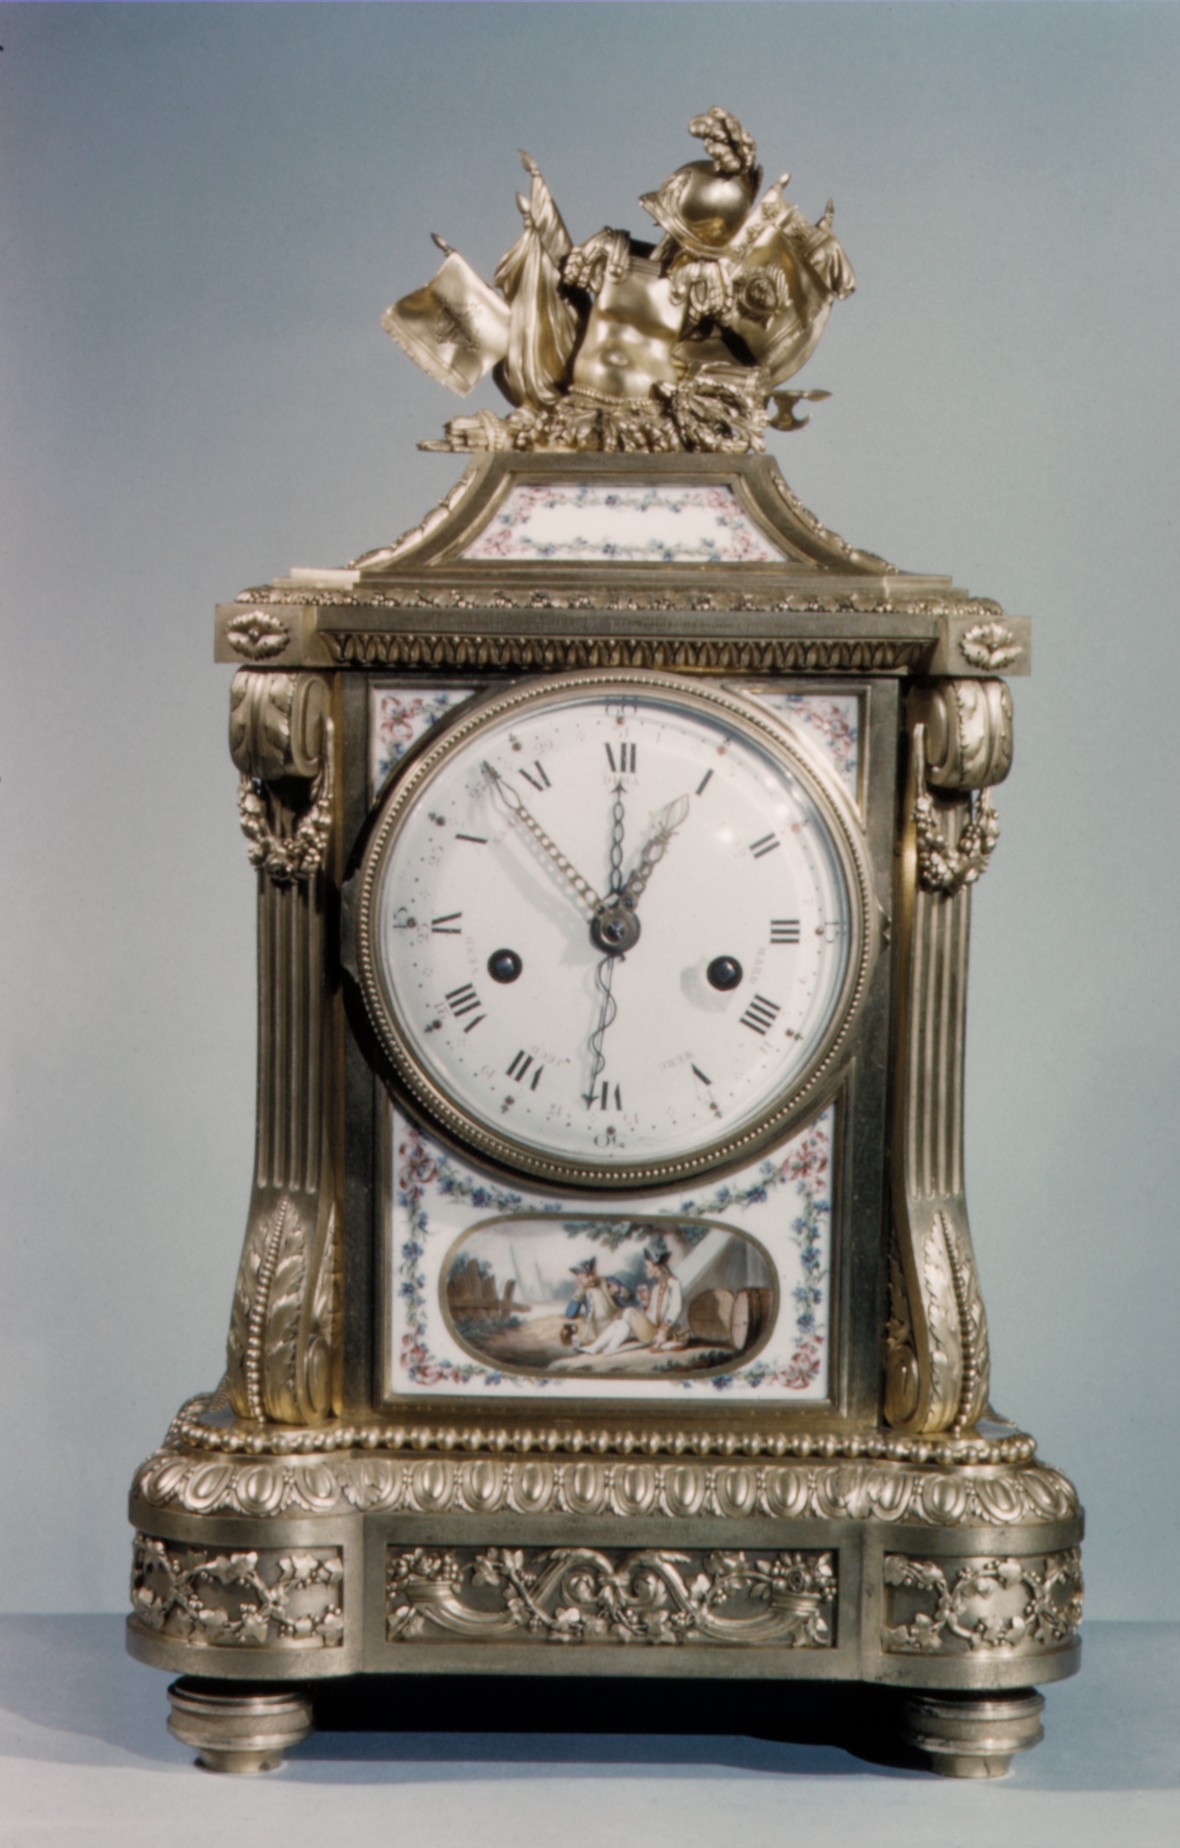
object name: clock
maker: sèvres manufactory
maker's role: manufactory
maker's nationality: french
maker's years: 1740-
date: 1775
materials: brass, enamel, gilt bronze, porcelain, steel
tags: human figures